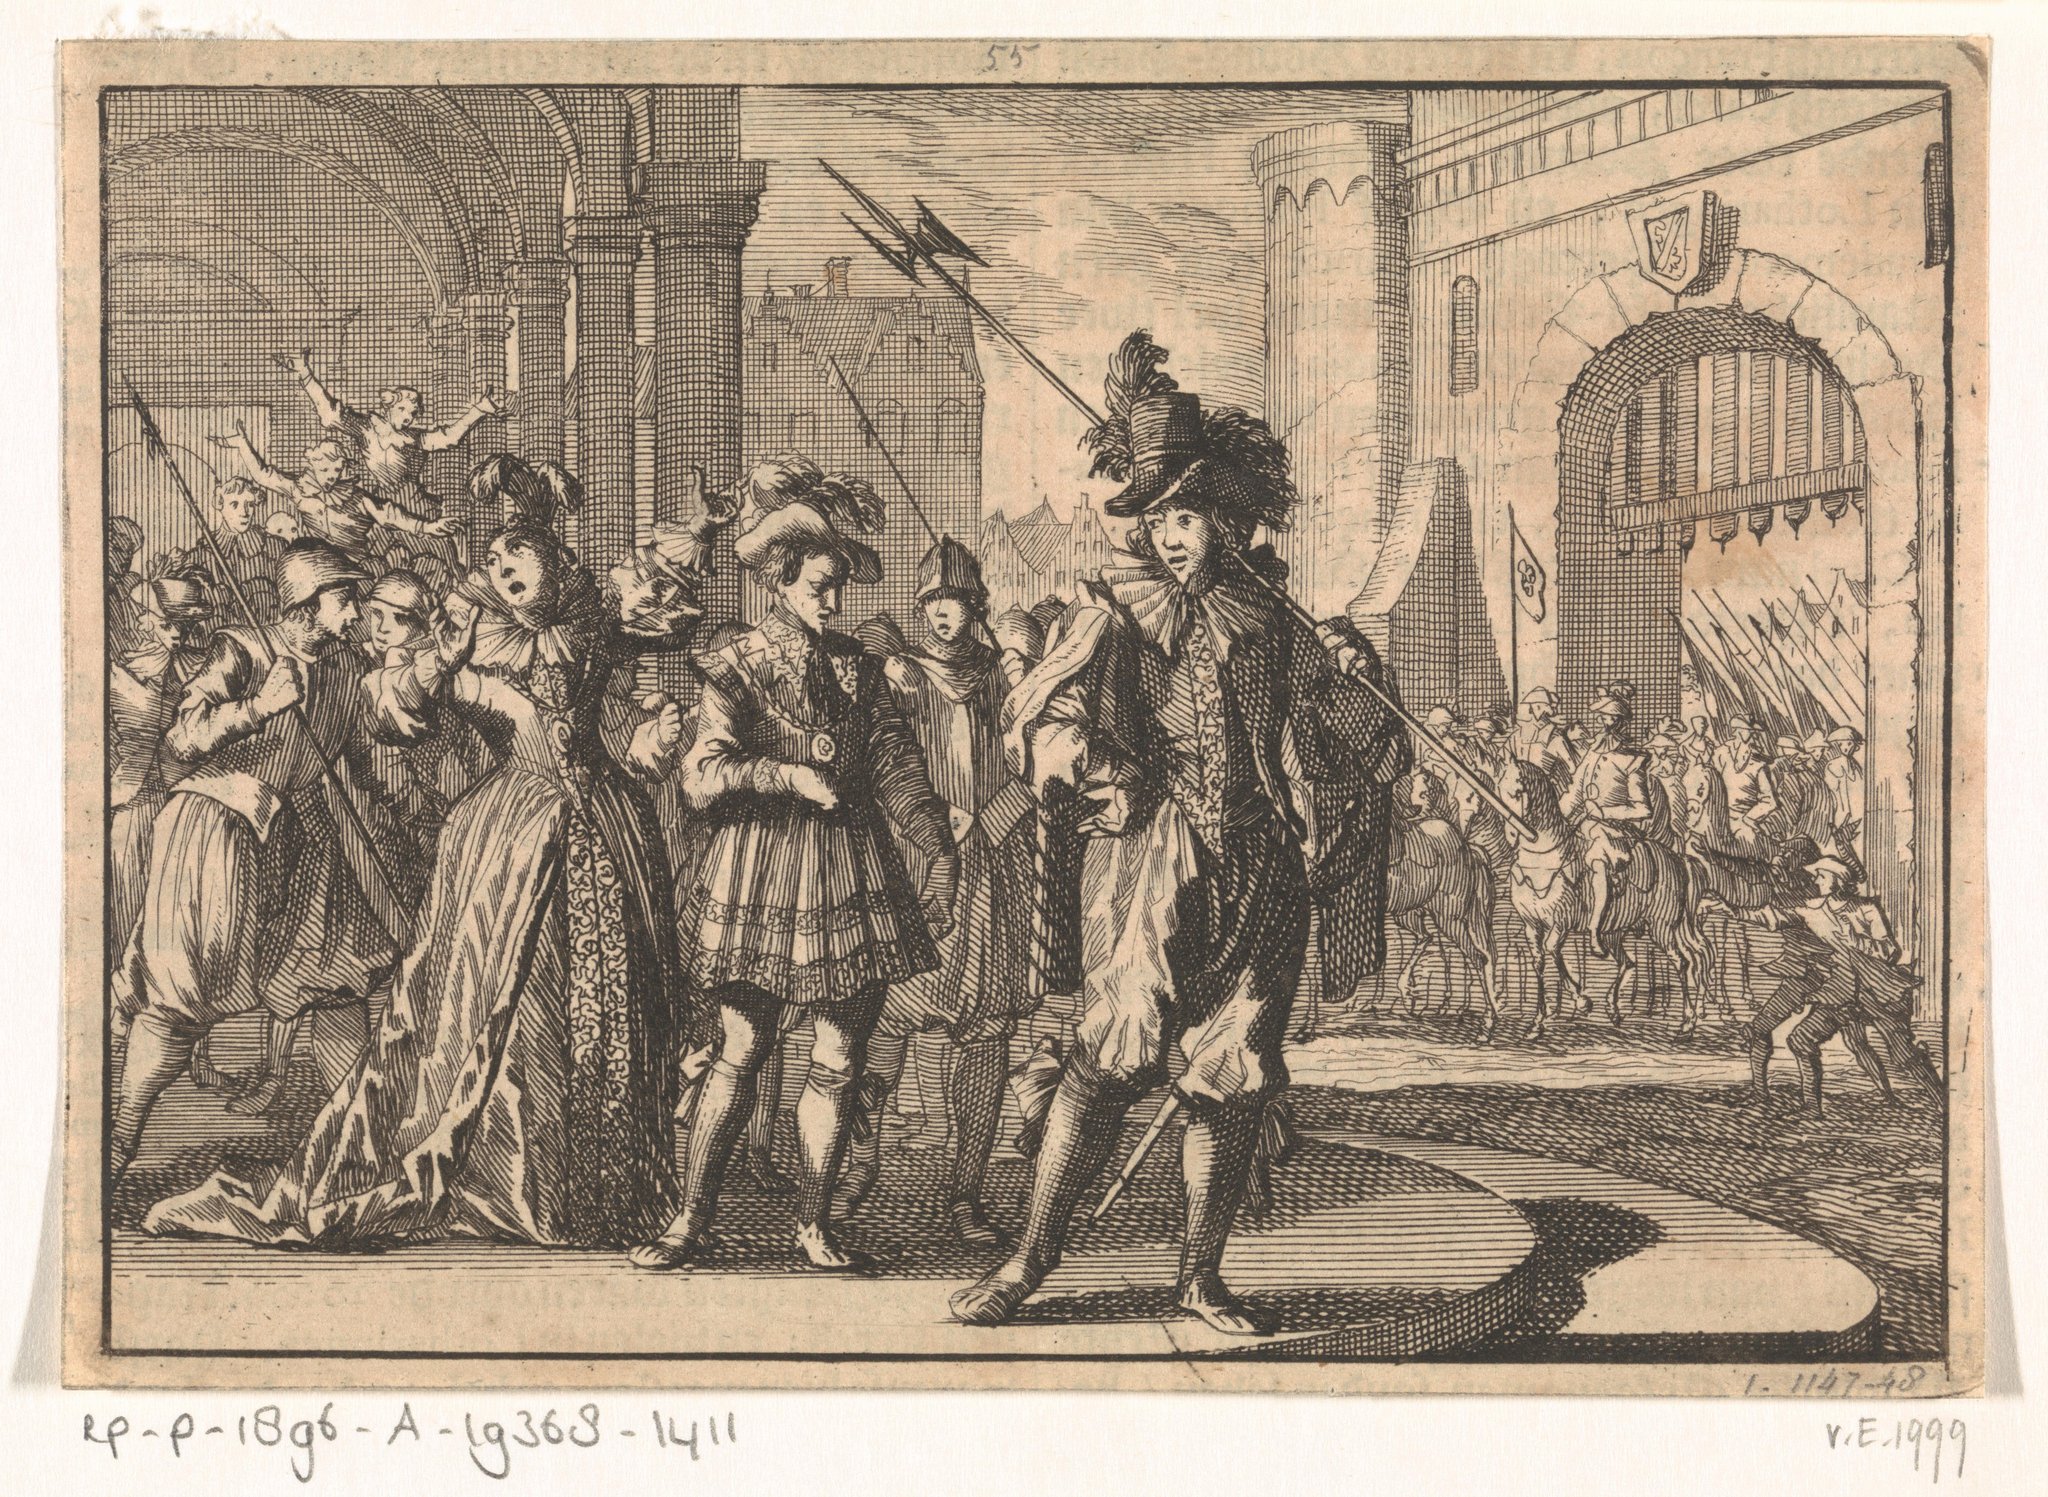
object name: print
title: Op bevel van koning Lodewijk XIII worden hertog Karel van Lotharingen en zijn vrouw gevangen genomen, 1633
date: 1698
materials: paper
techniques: etching, letterpress printing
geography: leiden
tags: lodewijk xiii (koning van frankrijk), arrest (of criminal)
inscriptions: collector's mark: Lugt 2228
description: Illustratie uit: Gottfried, Johann Ludwig. Historische kronyck; vervattende een (...) beschrijvingh der aldergedenckwaerdigste geschiedenissen des weerelds, van den aenvangh der scheppingh tot (...) 1576 (2 delen). Leiden: Pieter van der Aa, 1698, dl. I, p. 1147.